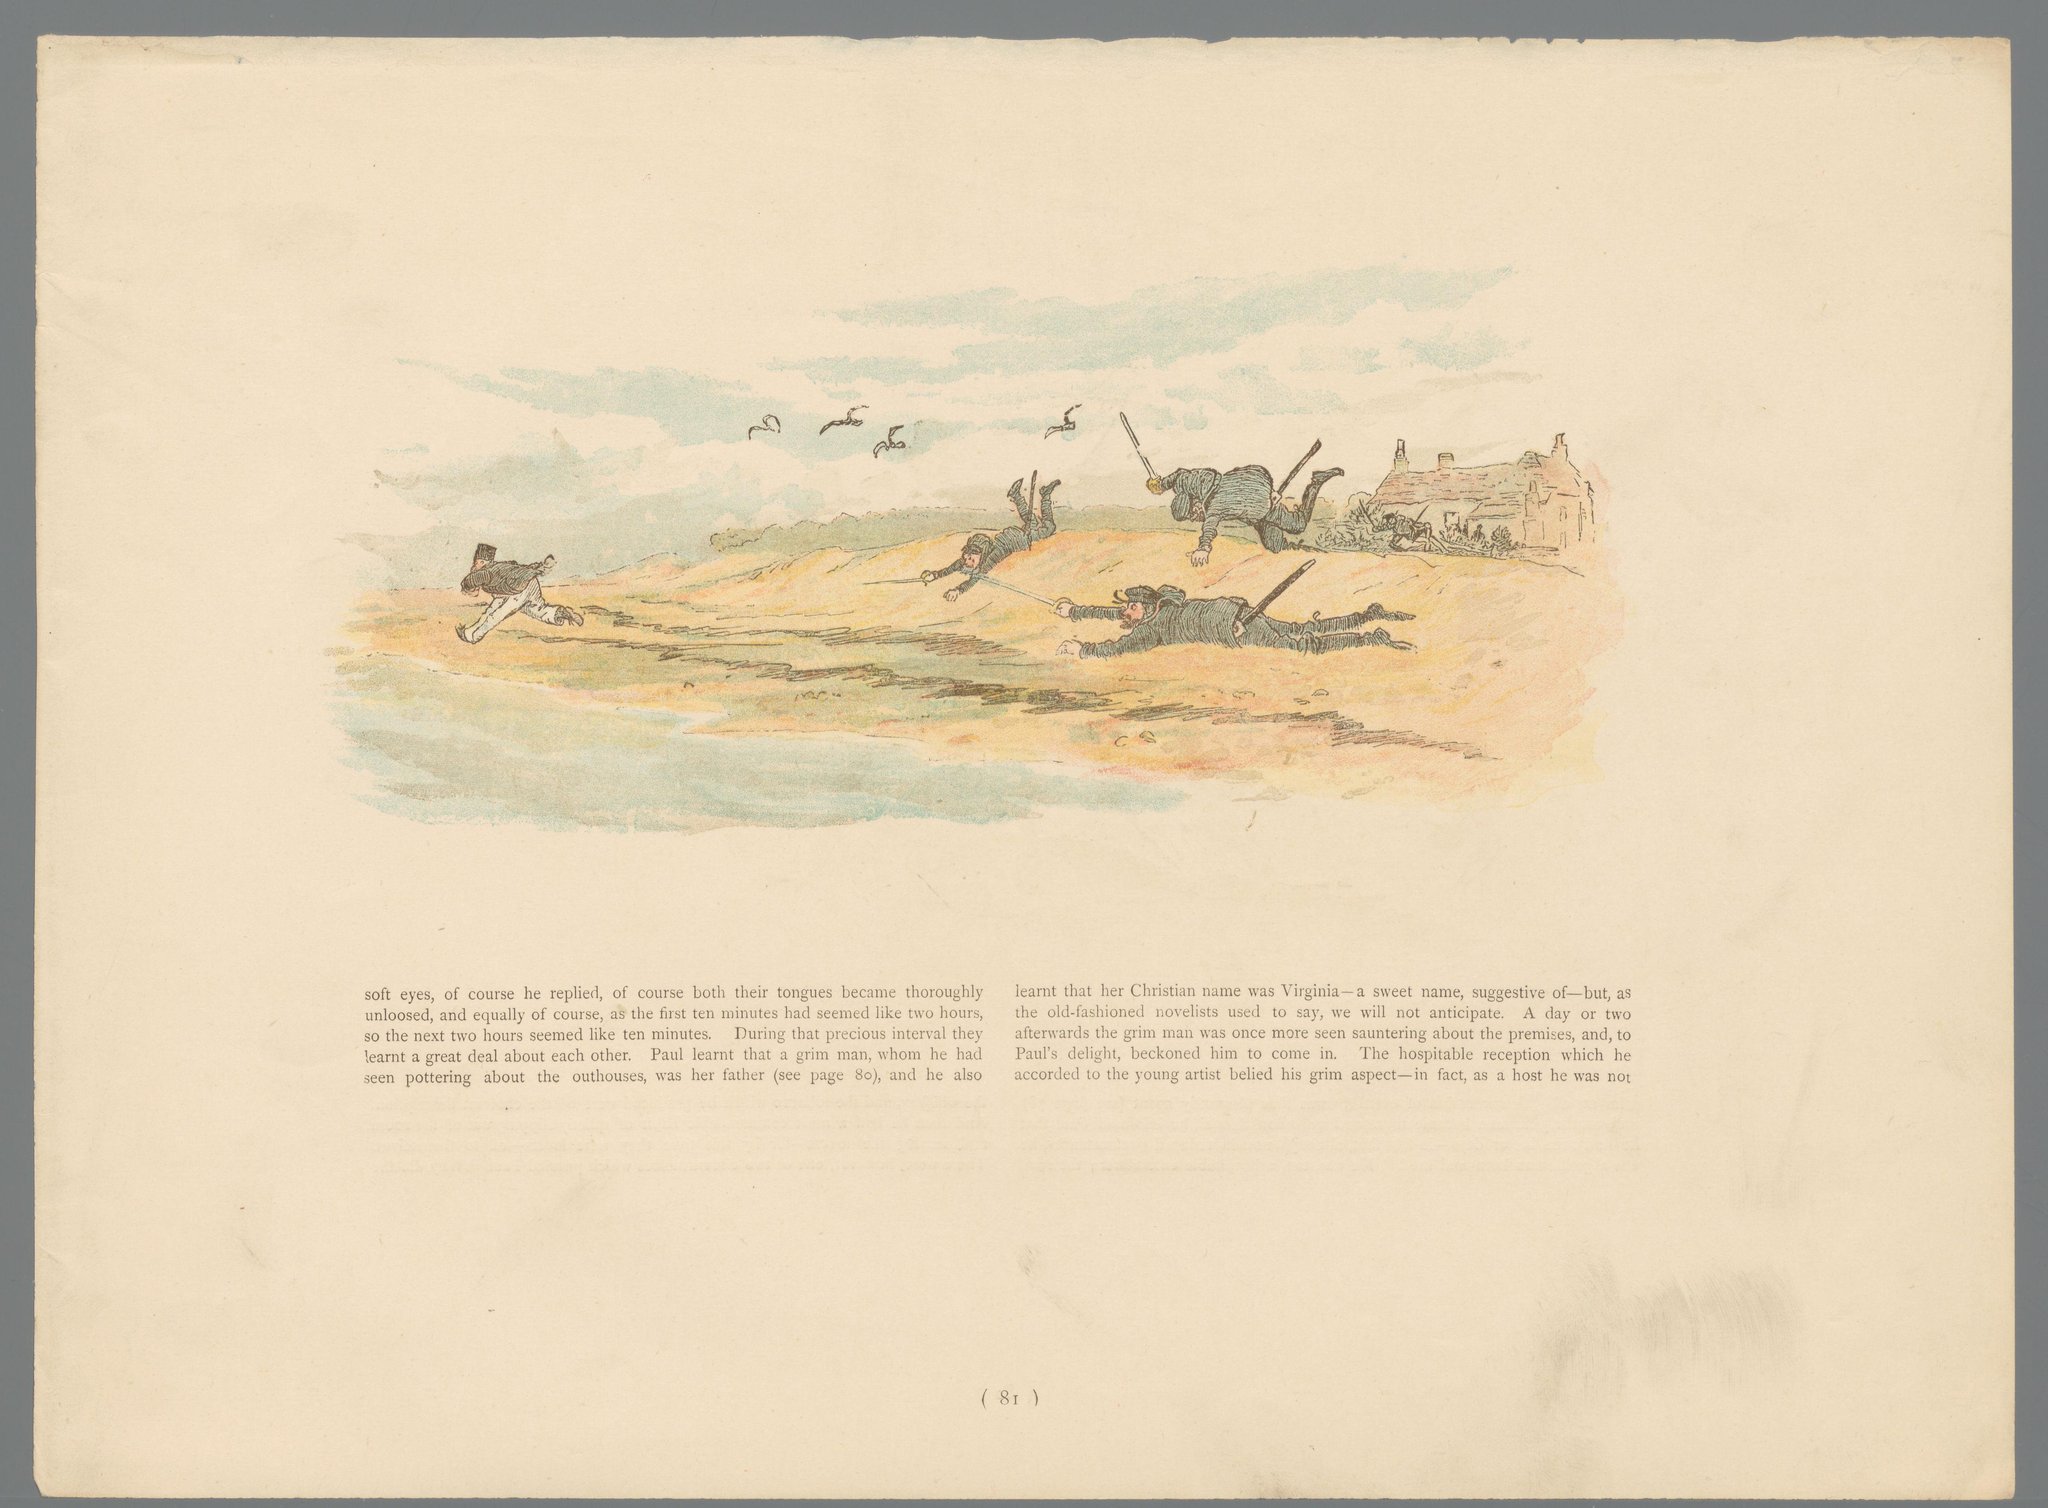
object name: book illustration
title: Drie gewapende mannen achtervolgen een man op het strand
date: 1889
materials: paper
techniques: wood engraving, letterpress printing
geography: london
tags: hacking and thrusting weapons: sword, flight, running away; pursuing, beach (+ landscape with figures, staffage)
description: Prent uit: Gleanings from the Graphic. Londen: George Routledge & Sons, 1889. Dit werk is een bundel van diverse illustraties die eerder verschenen in verschillende jaargangen van het Engelse weekblad 'The Graphic'. De bundel is na het overlijden van Randolph Caldecott uitgegeven.